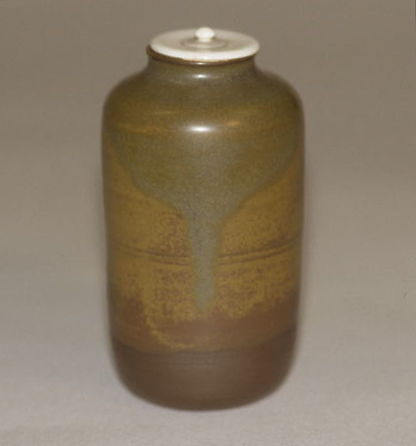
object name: tea jar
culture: japanese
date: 1700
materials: clay, glaze